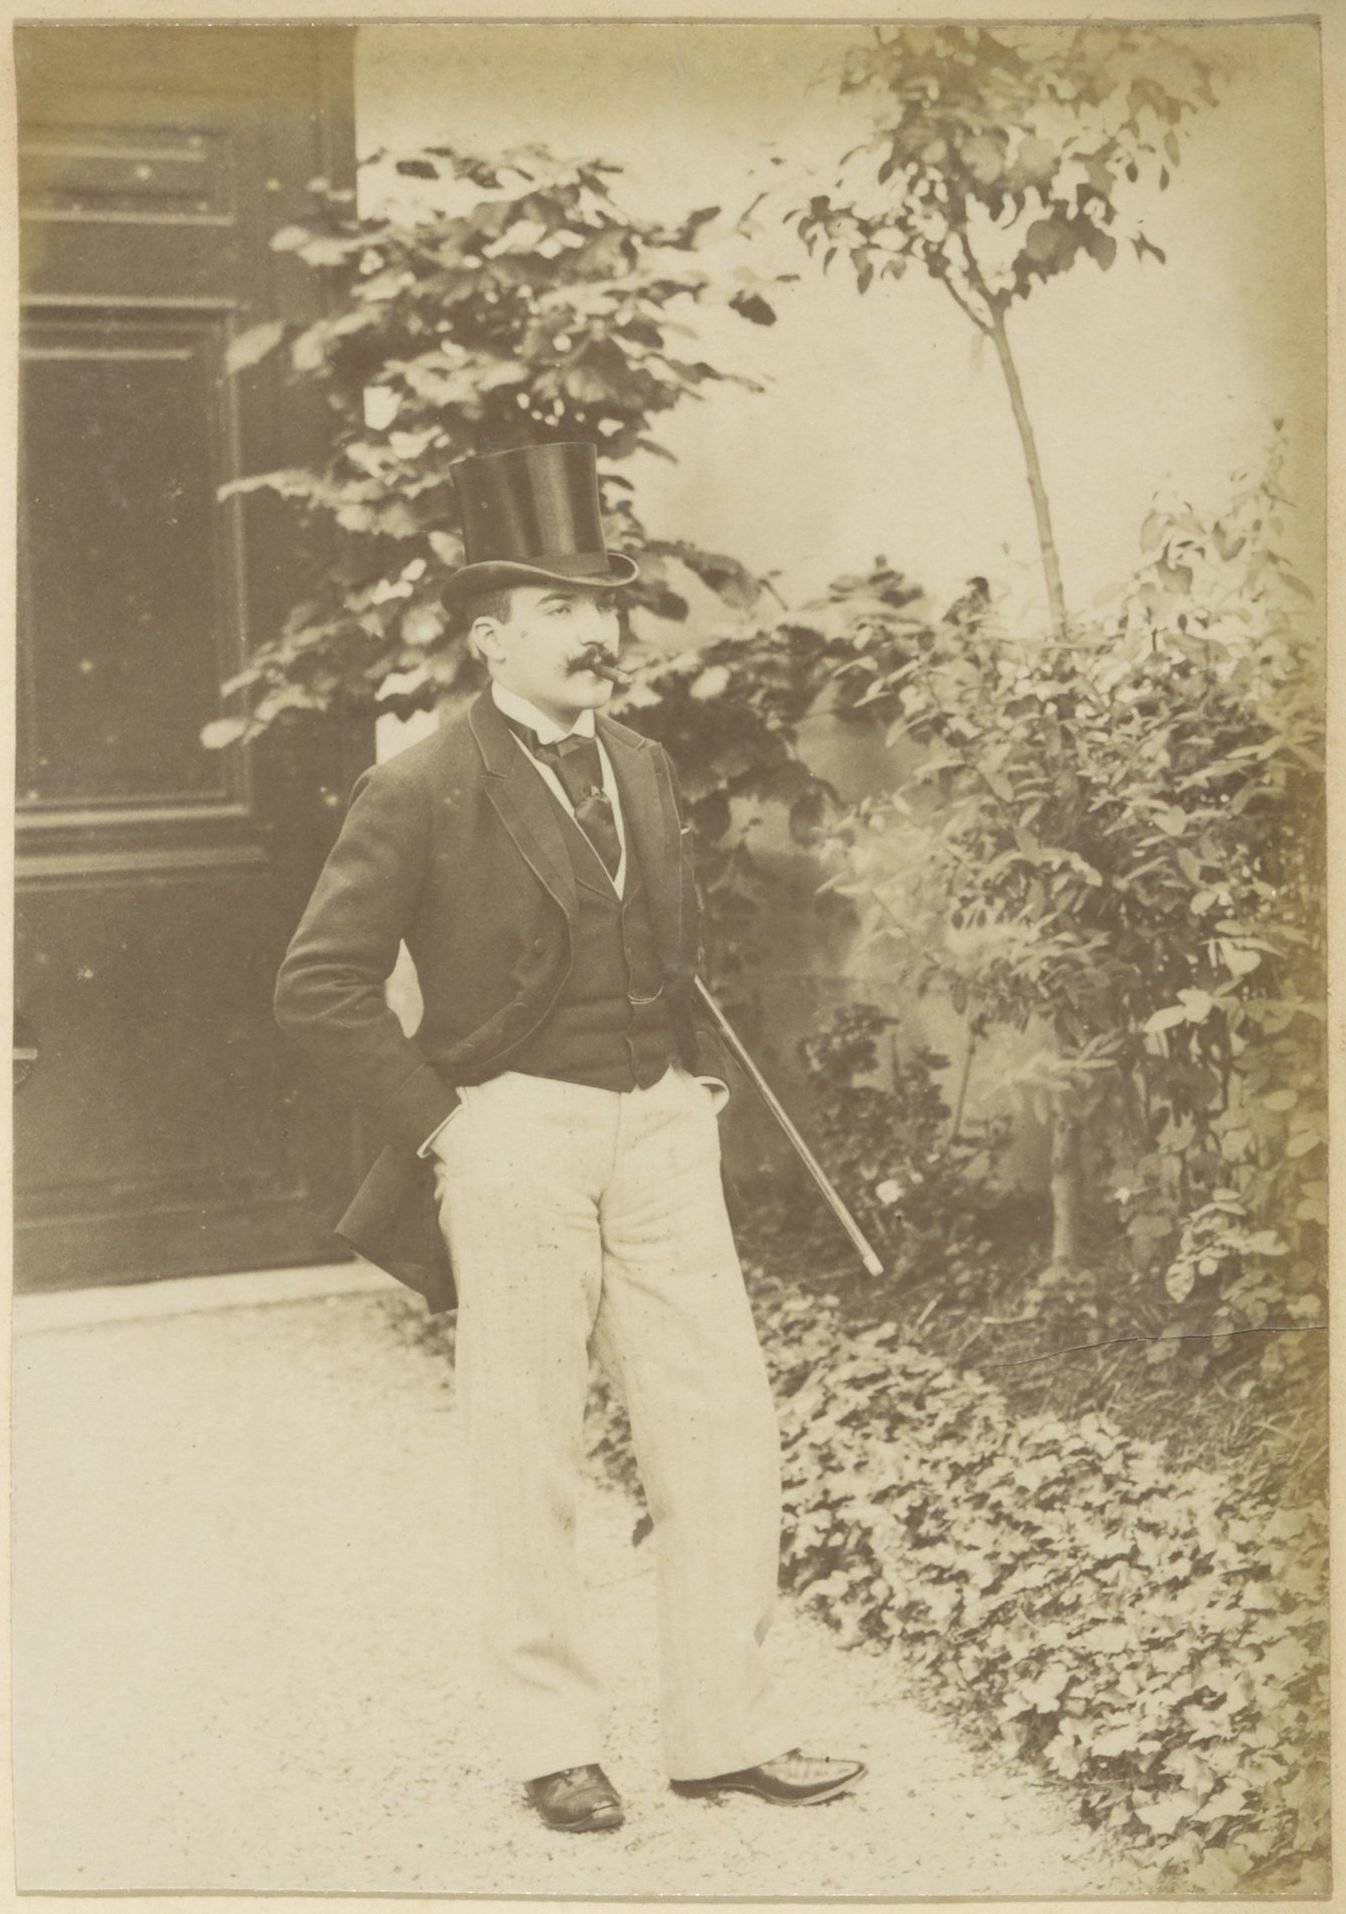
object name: photograph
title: Portret van een Franse man met een hoge hoed, een wandelstok en een sigaar, staand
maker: Anonymous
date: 1900-1910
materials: paper, photographic support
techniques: albumen print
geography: france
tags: hand in the pocket - aa - both arms or hands, cigar, walking-stick, staff, adult man, head-gear: top hat, france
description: Onderdeel van Fotoalbum van een Franse amateurfotograaf met opnames van een familie, distilleerderij Delizy & Doistau Fils, het leger en bezienswaardigheden in Frankrijk.